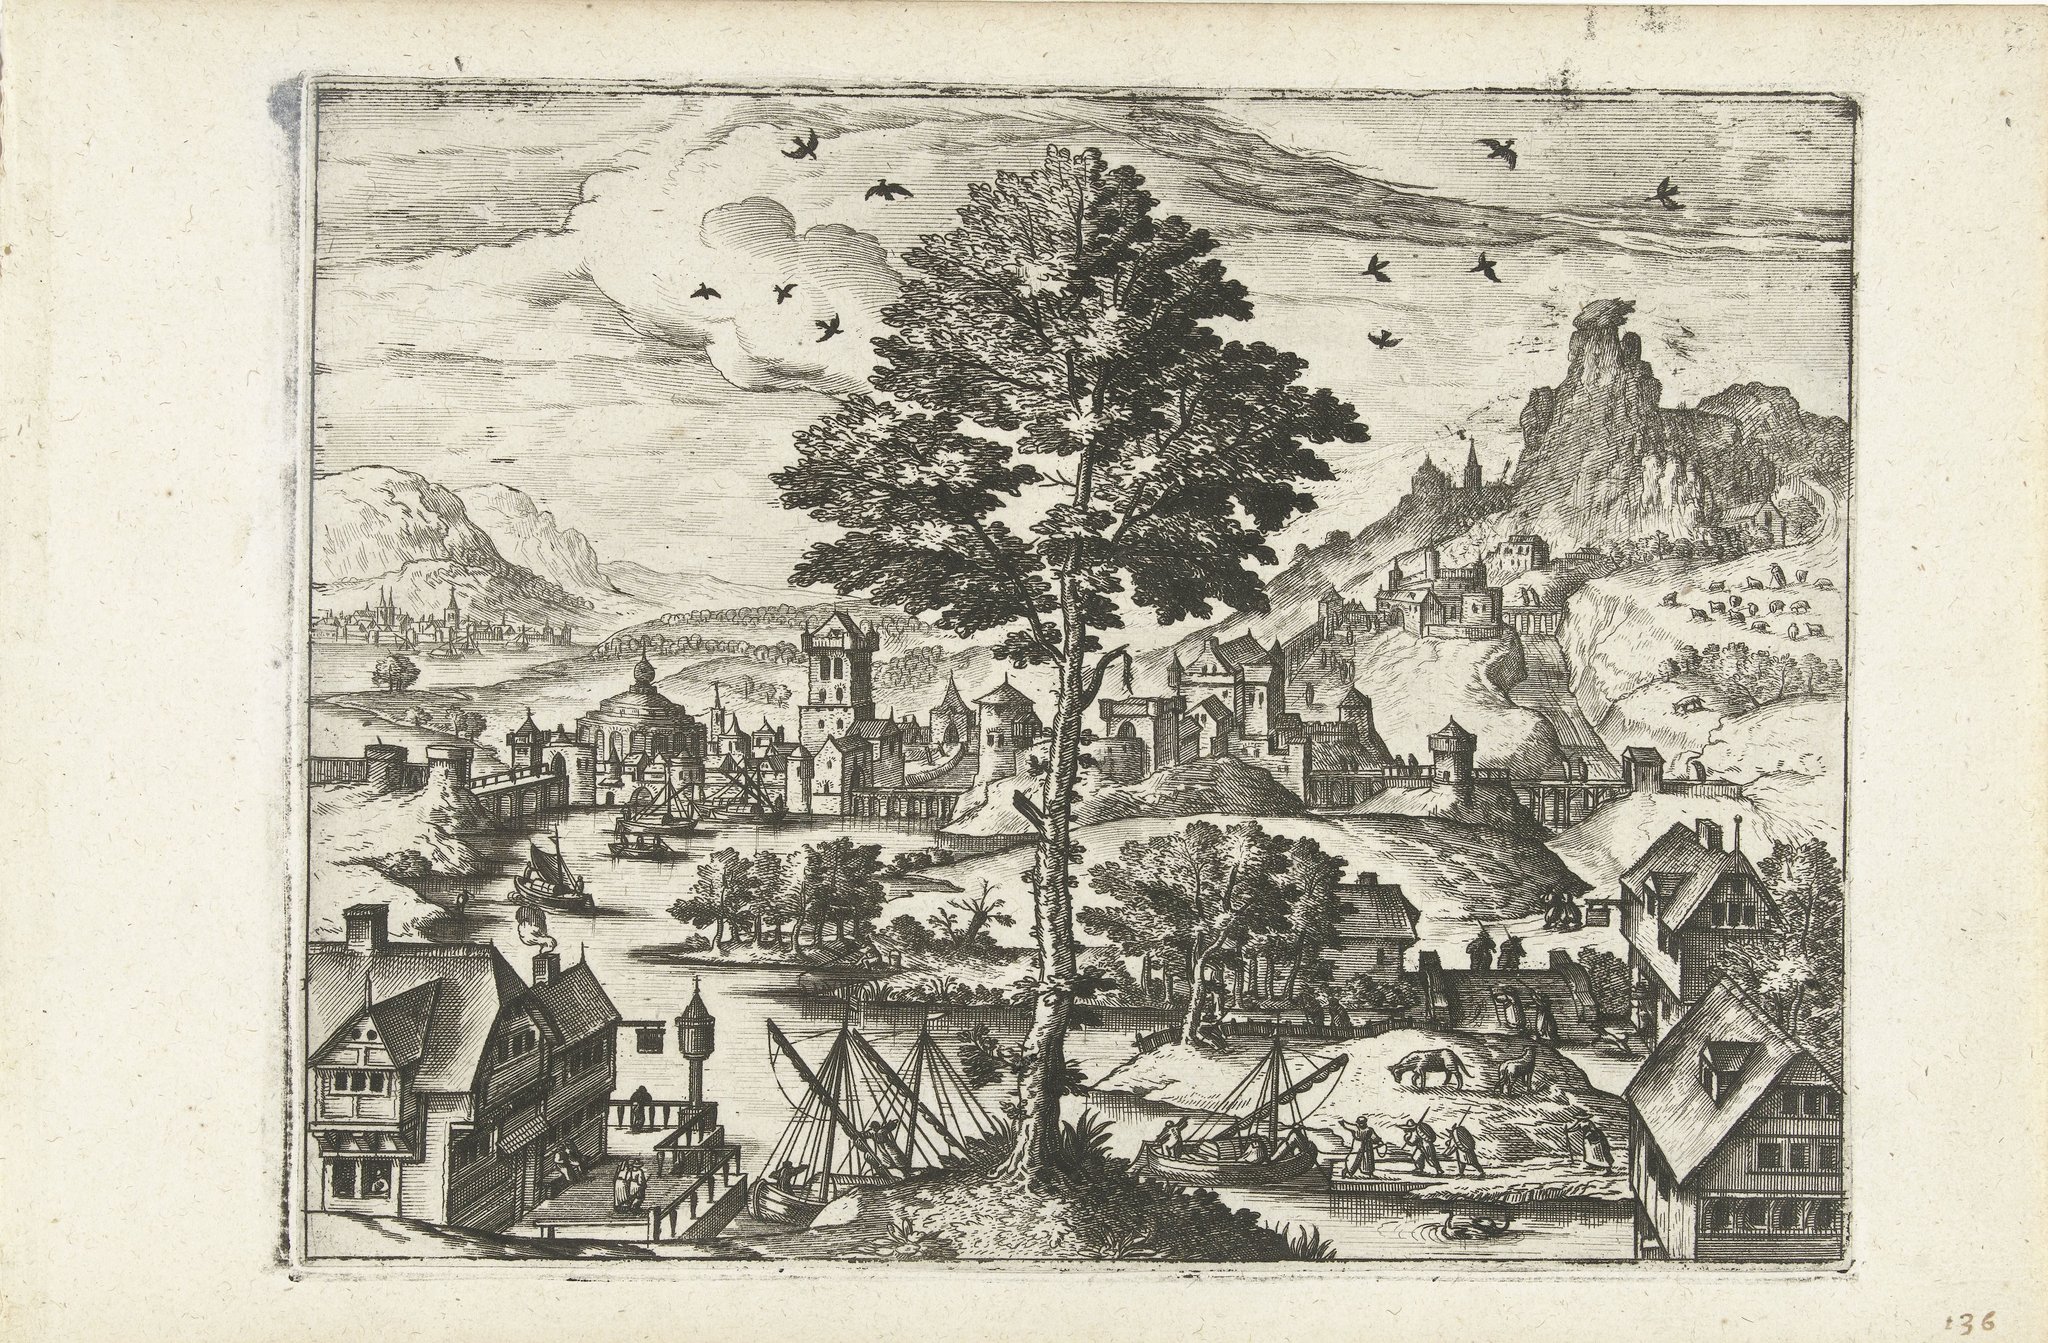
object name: print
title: Landschappen, zeegezichten en fantasierijke stadsgezichten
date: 1570-1580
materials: paper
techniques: engraving, etching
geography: antwerp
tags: city-view, and landscape with man-made constructions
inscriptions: collector's mark: Lugt 2228, collector's mark: Lugt 2760, number: ‘136’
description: Een stadje aan een rivier, die zich door een heuvelachtig landschap kronkelt. Op het water scheepjes, links een herberg. In het midden een hoge boom.